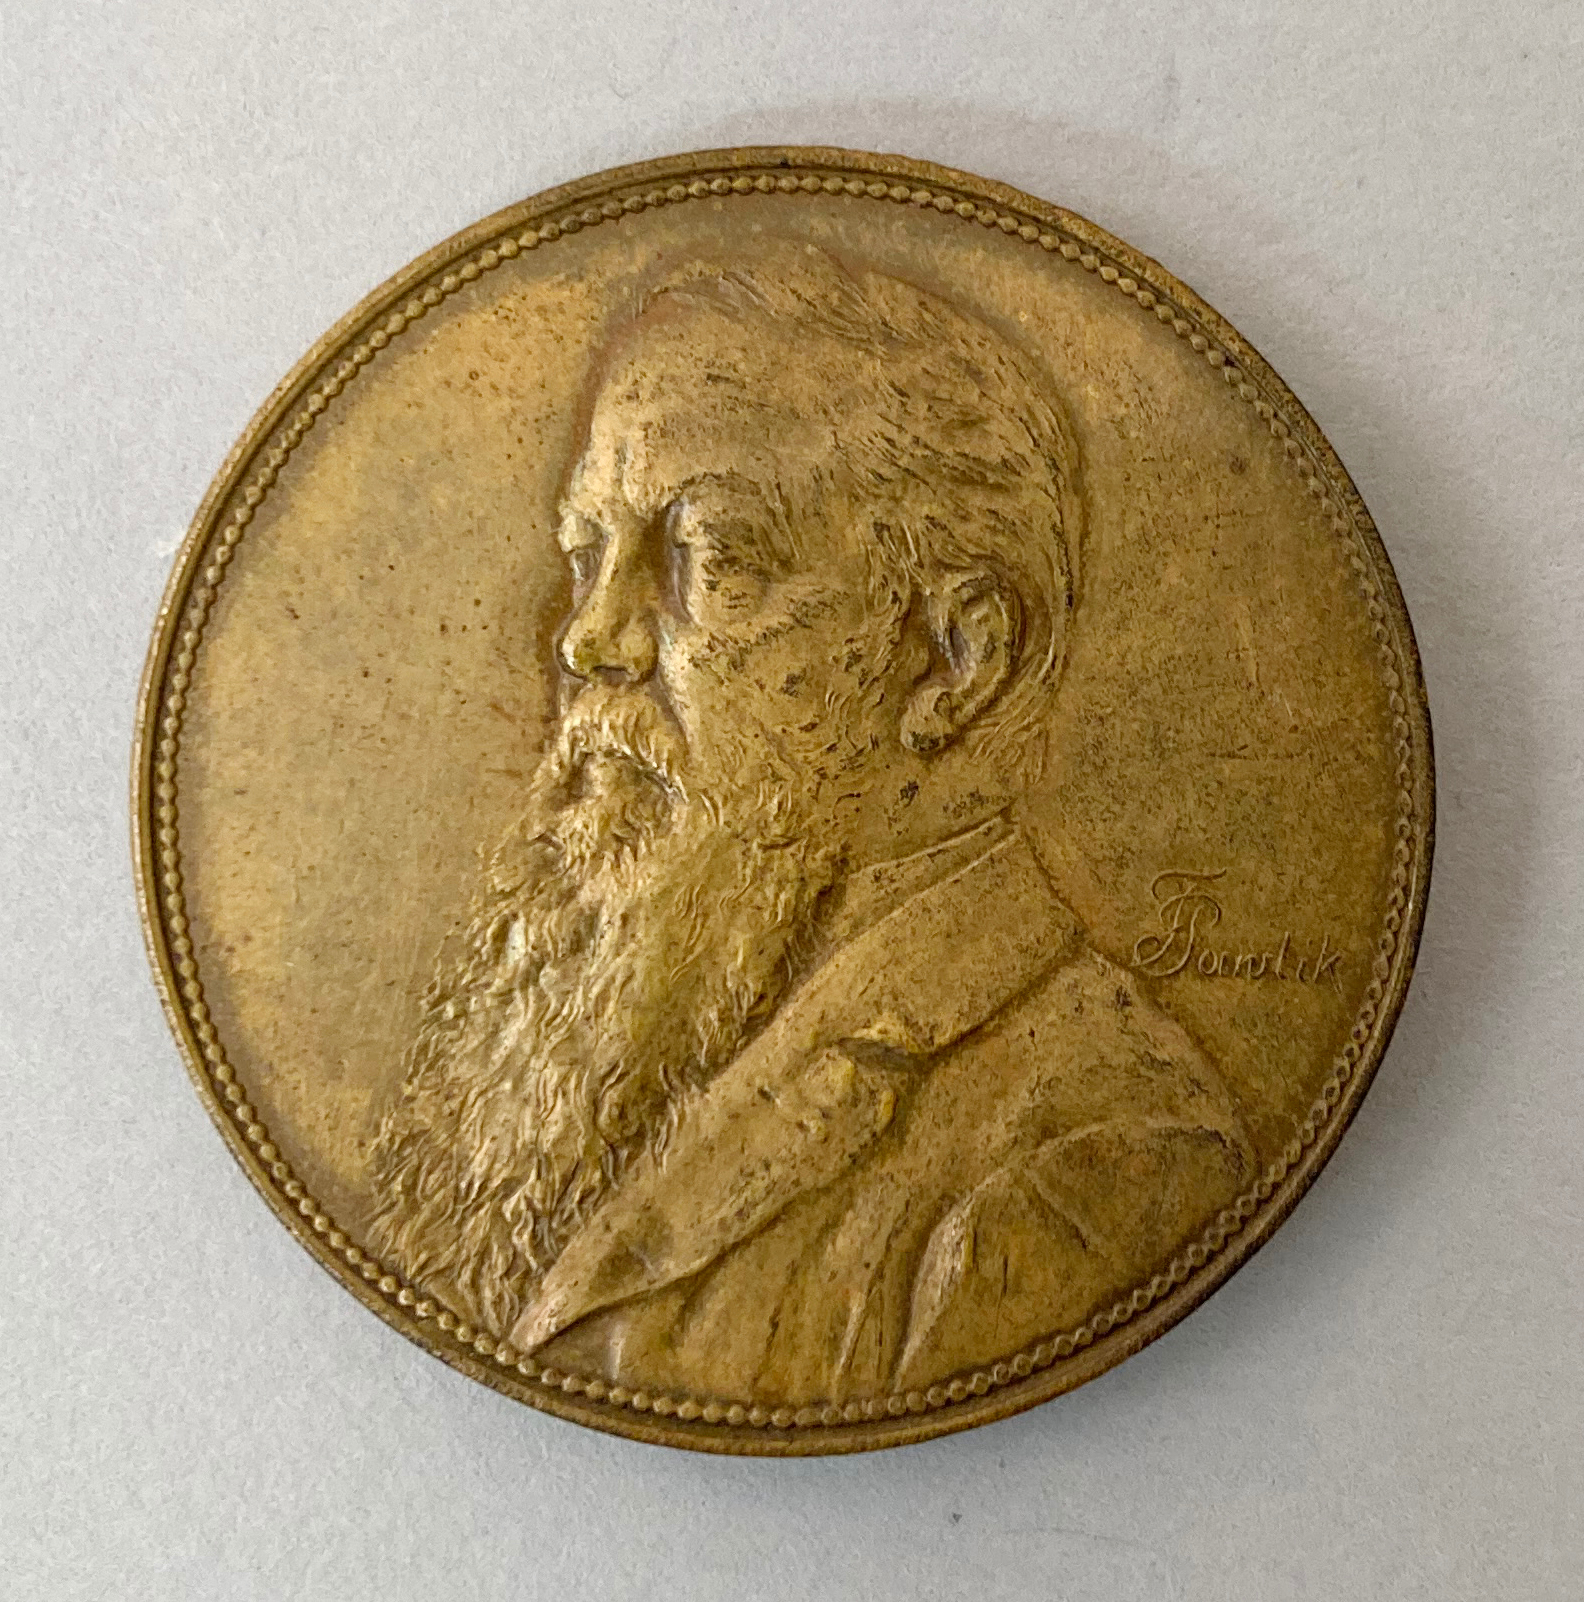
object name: medal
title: Alois Richter (1849–1894)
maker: franz xaver pawlik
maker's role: artist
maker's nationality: austrian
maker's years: 1865-1906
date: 1894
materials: bronze